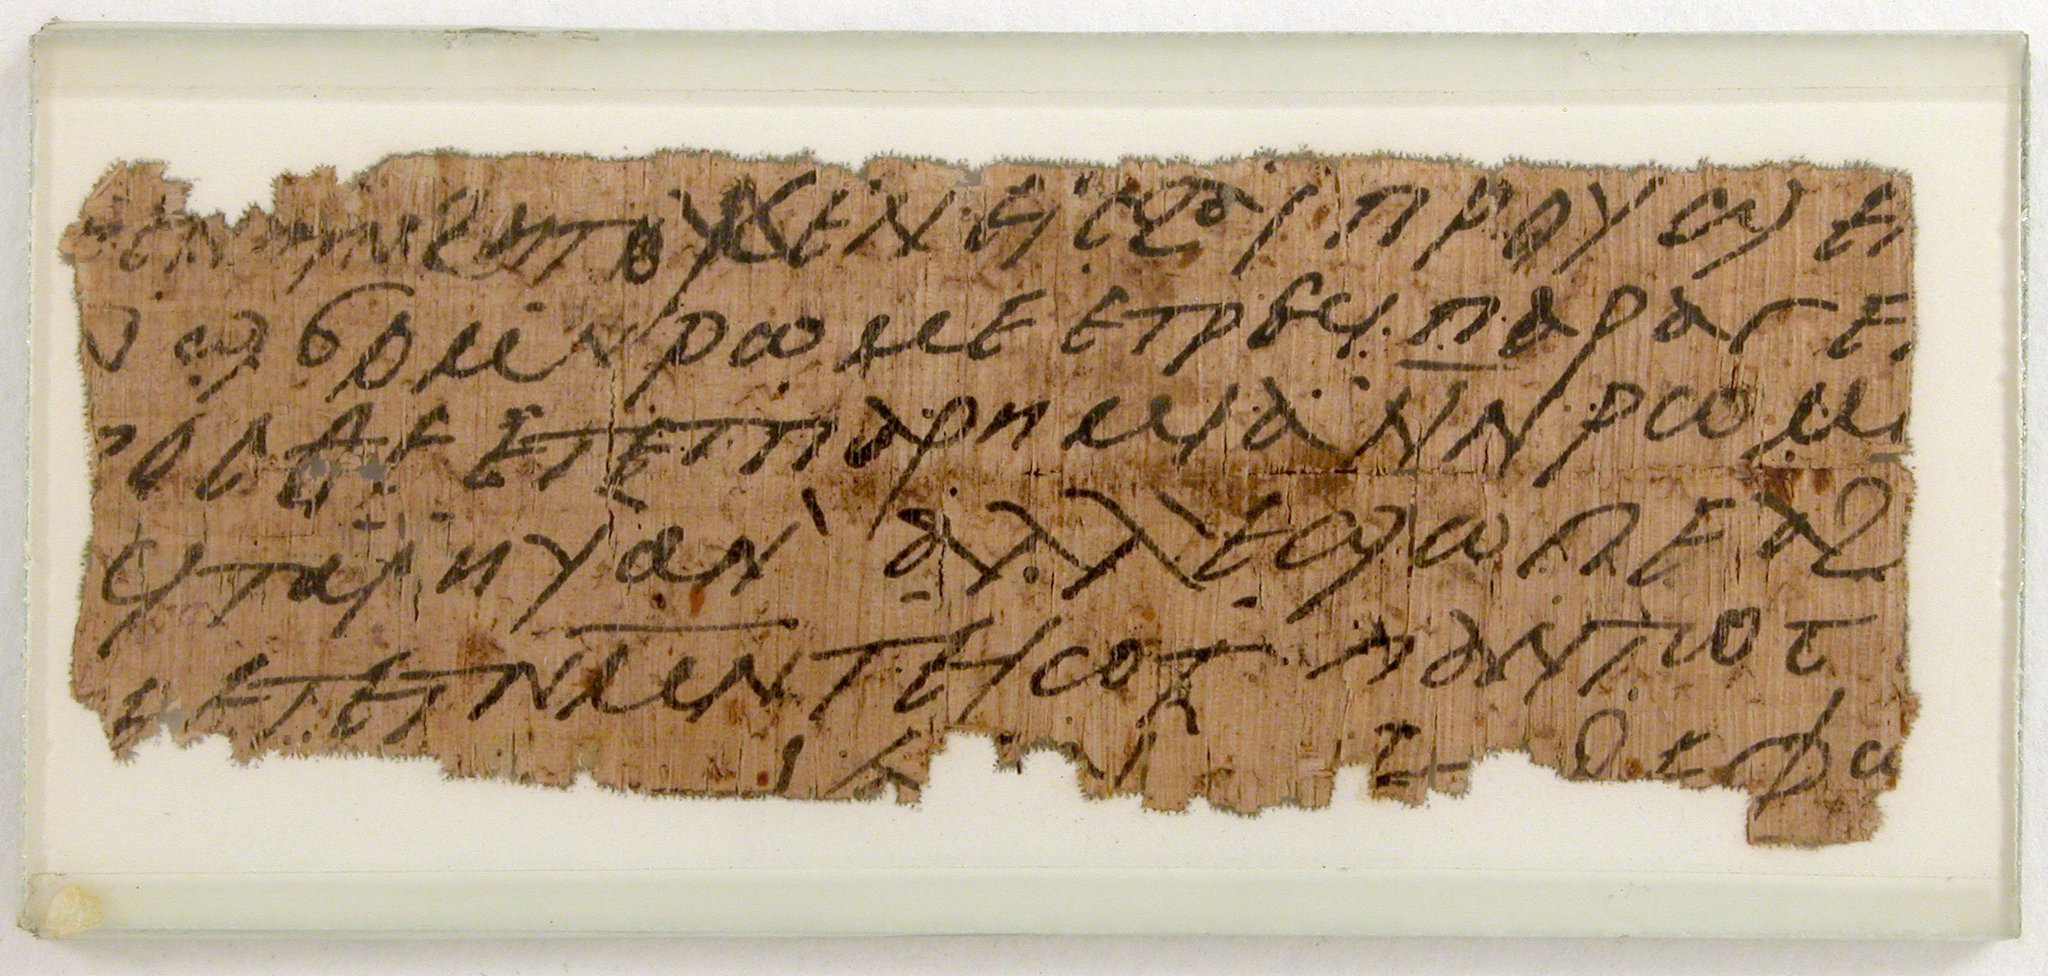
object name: fragment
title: Papyrus Fragment of a Letter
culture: coptic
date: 601-700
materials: ink, papyrus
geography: egypt